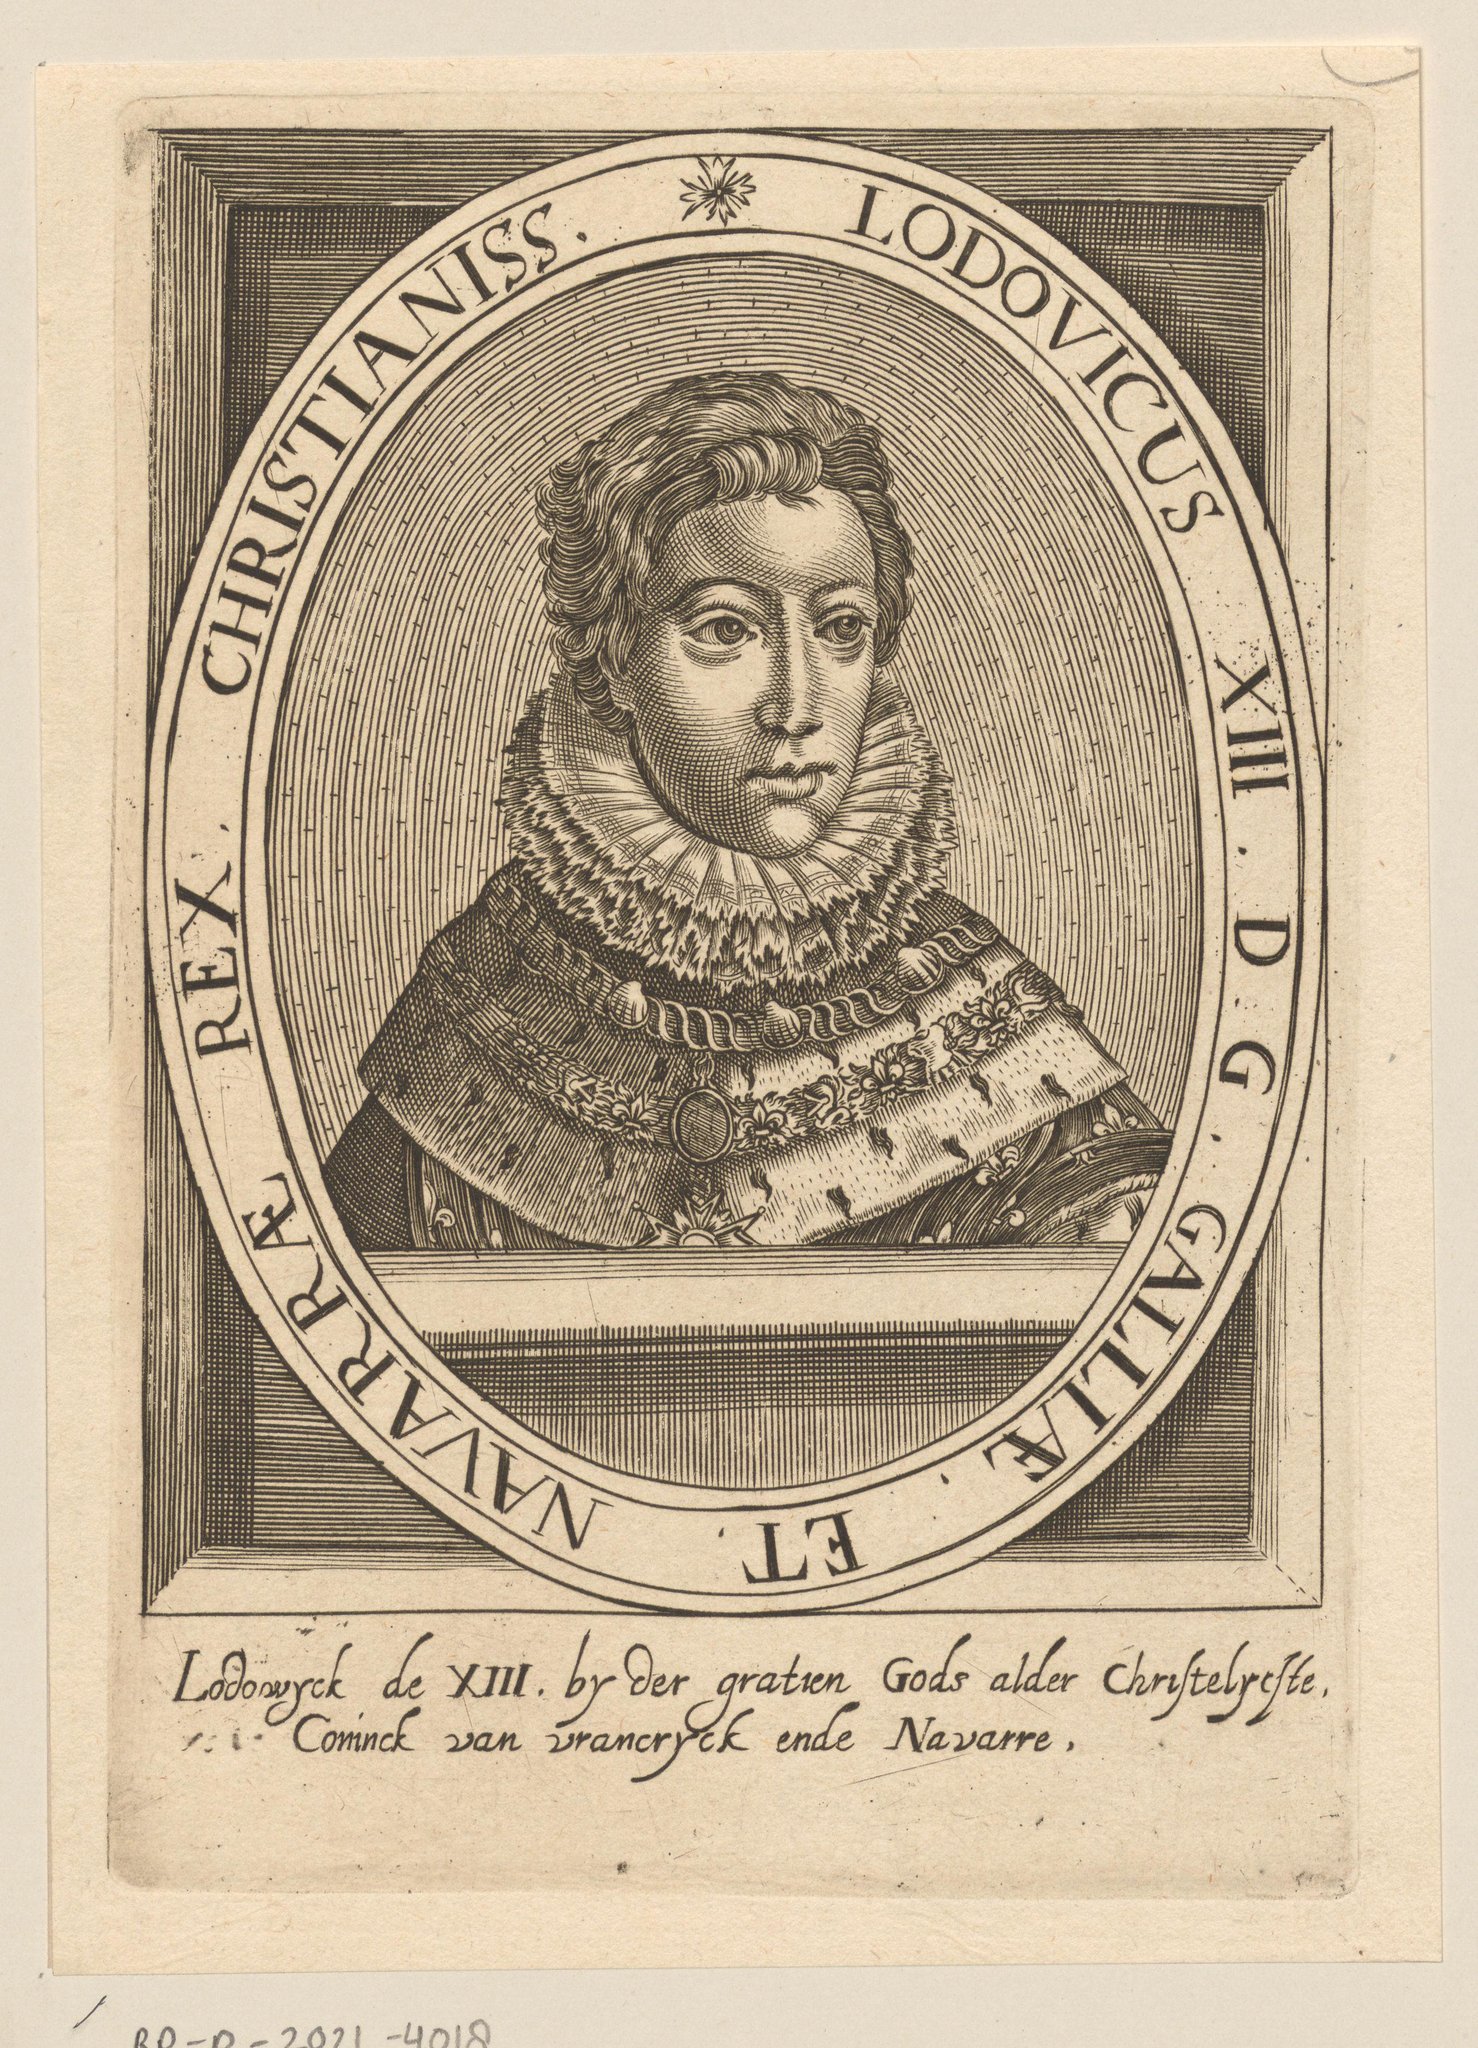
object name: print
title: Portret van Lodewijk XIII van Frankrijk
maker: Anonymous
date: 1624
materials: paper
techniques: engraving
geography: low countries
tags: lodewijk xiii (koning van frankrijk), historical persons, king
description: Prent waarschijnlijk uit: Baudart, Willem. Memoryen ofte cort verhael der gedenck-weerdichste so kercklicke als werltliche gheschiedenissen (...). Arnhem: Jan Jansz., 1624.